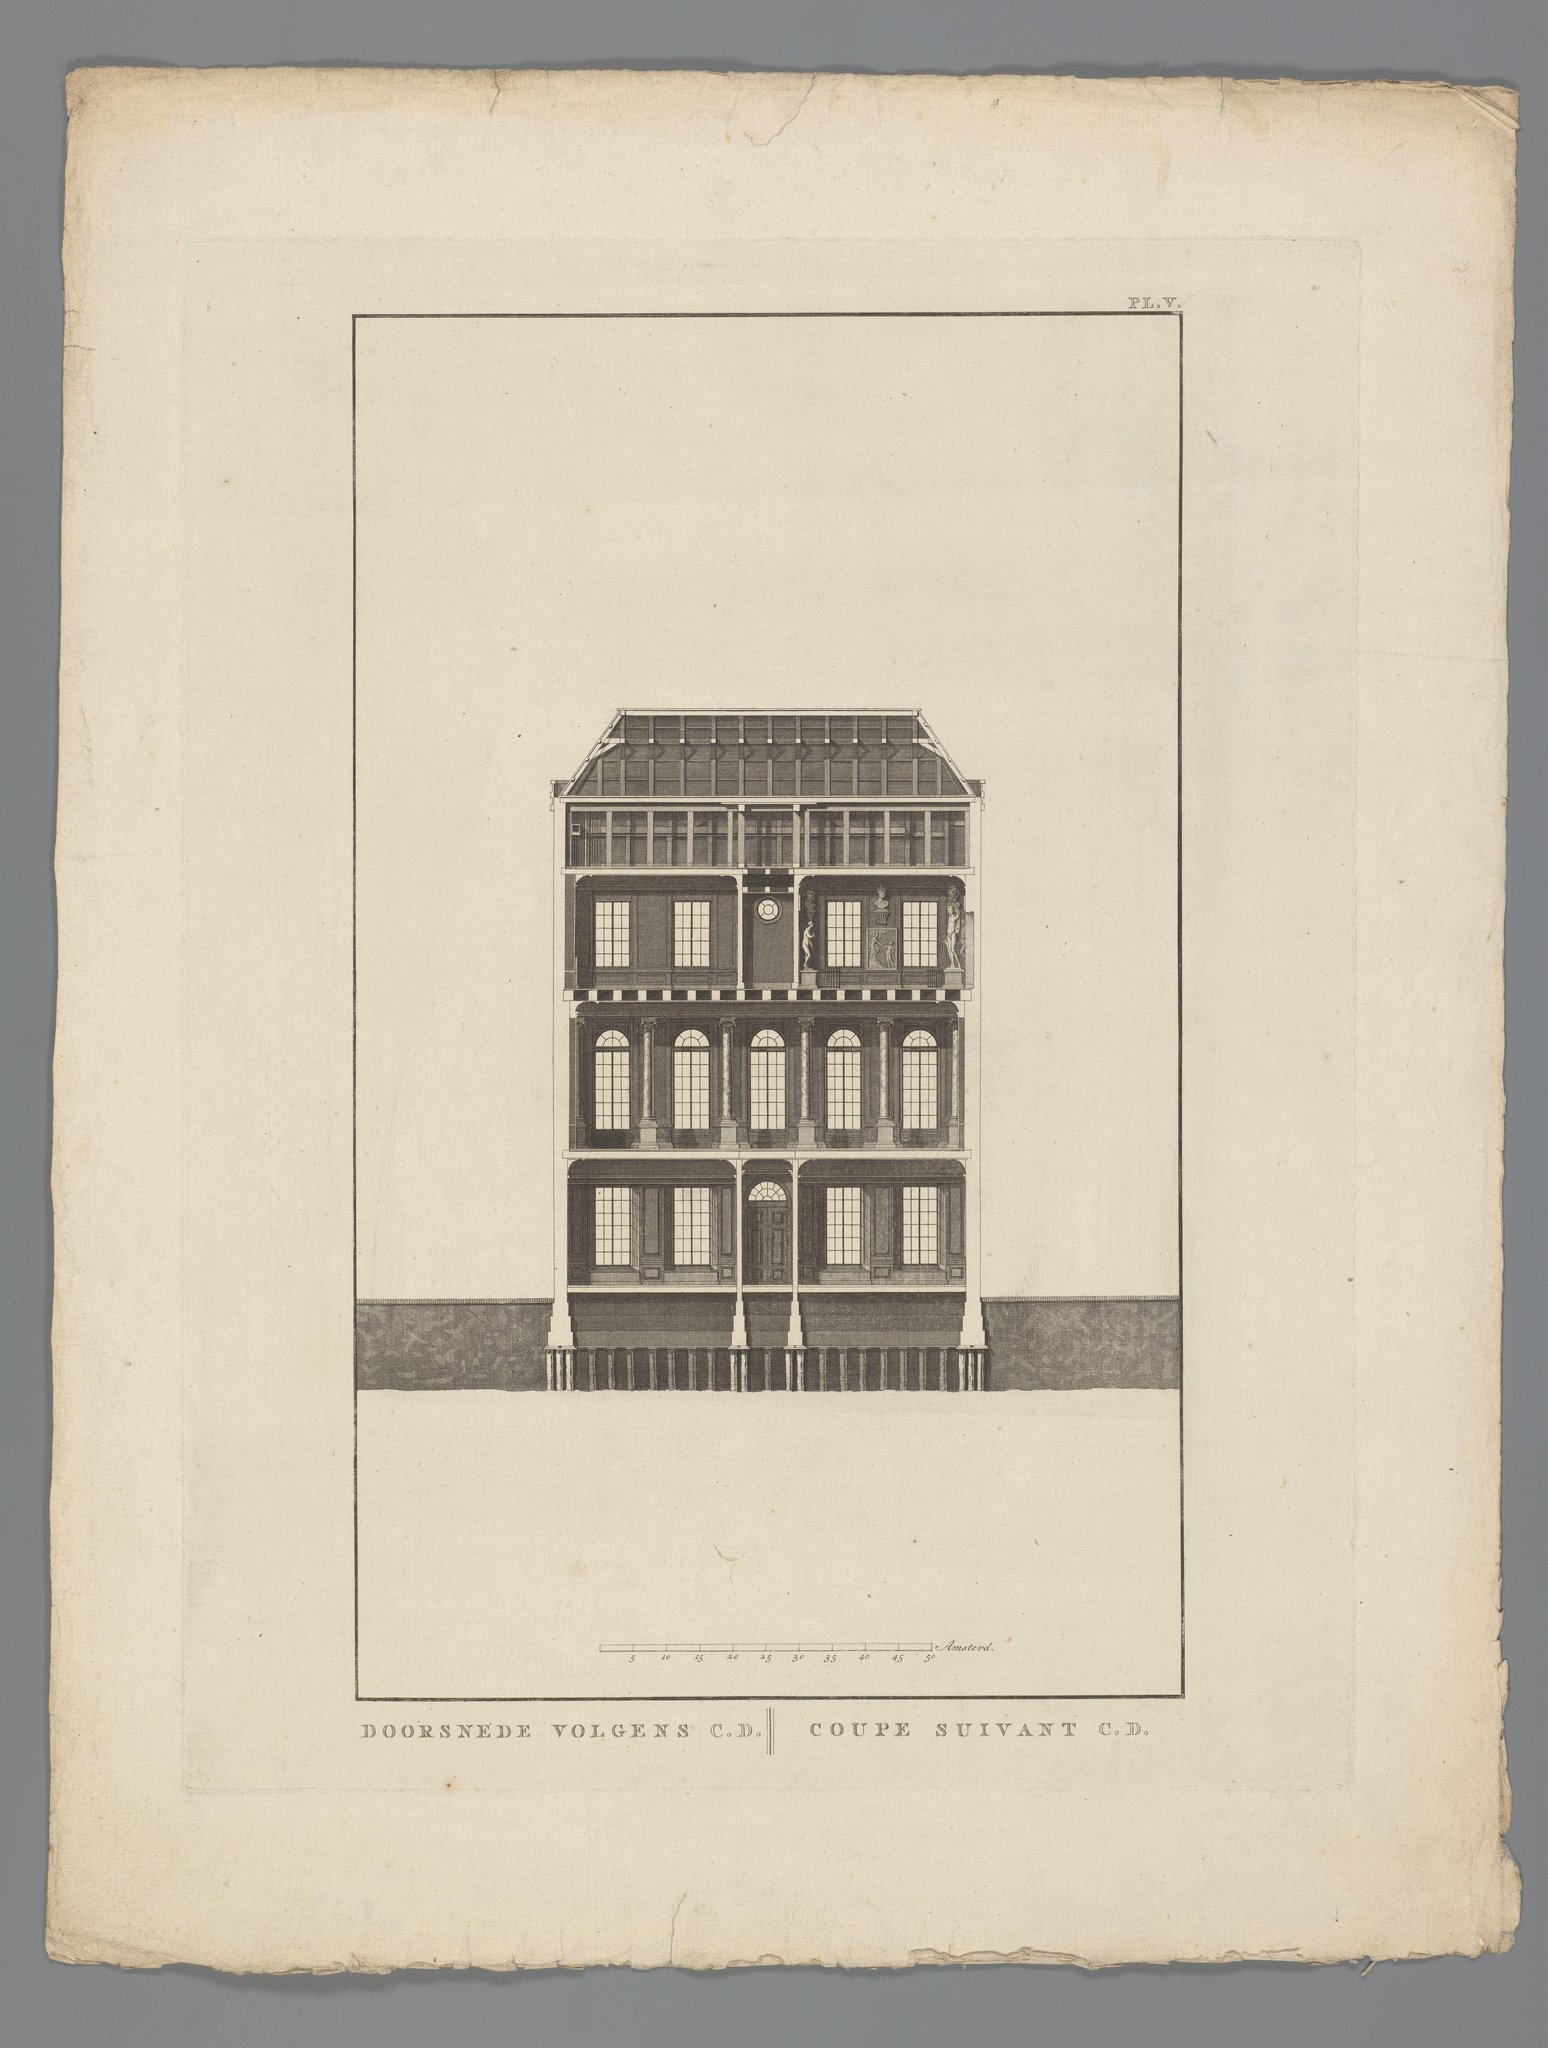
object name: book illustration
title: Grondteekeningen van het Gebouw der Maatschappije van Verdiensten, ter spreuke voerende: Felix Meritis (...) / Détails d'architecture de l'edifice de la Société des Arts et des Sciences, sous la devise de Felix Meritis (...)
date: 1789-1799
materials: paper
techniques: etching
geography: amsterdam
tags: architectural design or model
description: Felix Meritis is de naam van een voormalig genootschap en het bijbehorende gebouw aan de Keizersgracht 324 te Amsterdam. Van 1988 tot 2014 was de Stichting Felix Meritis in het pand gevestigd met een Europees Centrum voor Kunst, Cultuur en Wetenschap. Prent uit: Grondteekeningen van het gebouw der Maatschapije van verdiensten, ter spreuke voerende : Felix Meritis (...). = Détails d'architecture de l'edifice de la Société (...) Felix Meritis. Amsterdam: Cornelis Sebille Roos, [1789-1799].